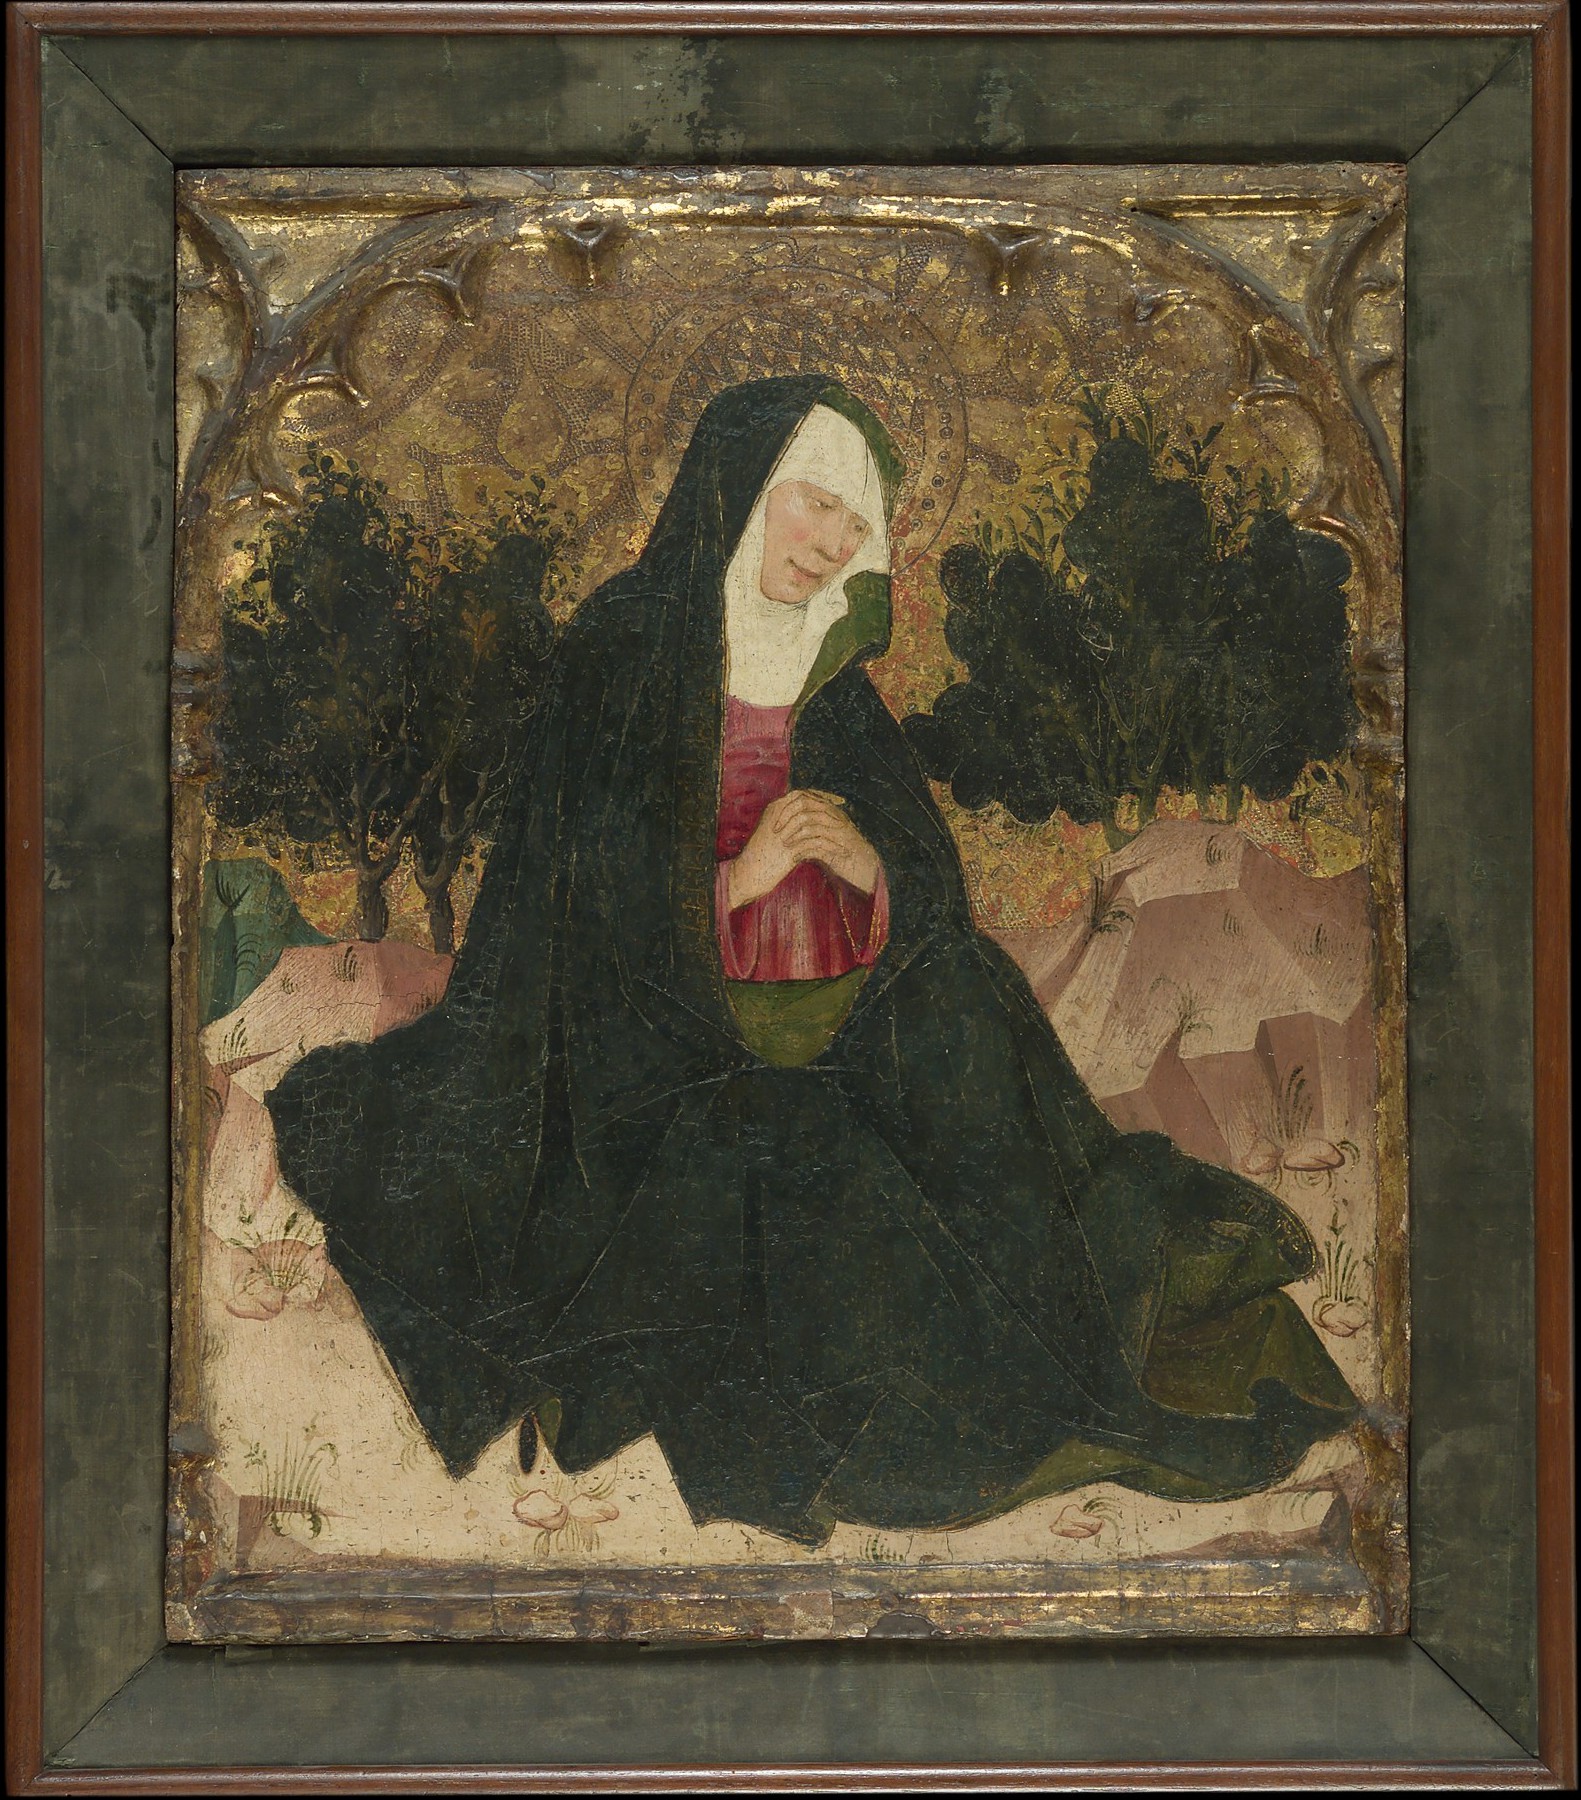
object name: painting, banco panel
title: The Virgin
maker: spanish (catalan) painter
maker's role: artist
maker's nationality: spanish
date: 1445-1455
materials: gold leaf, oil, paint, wood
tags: virgin mary